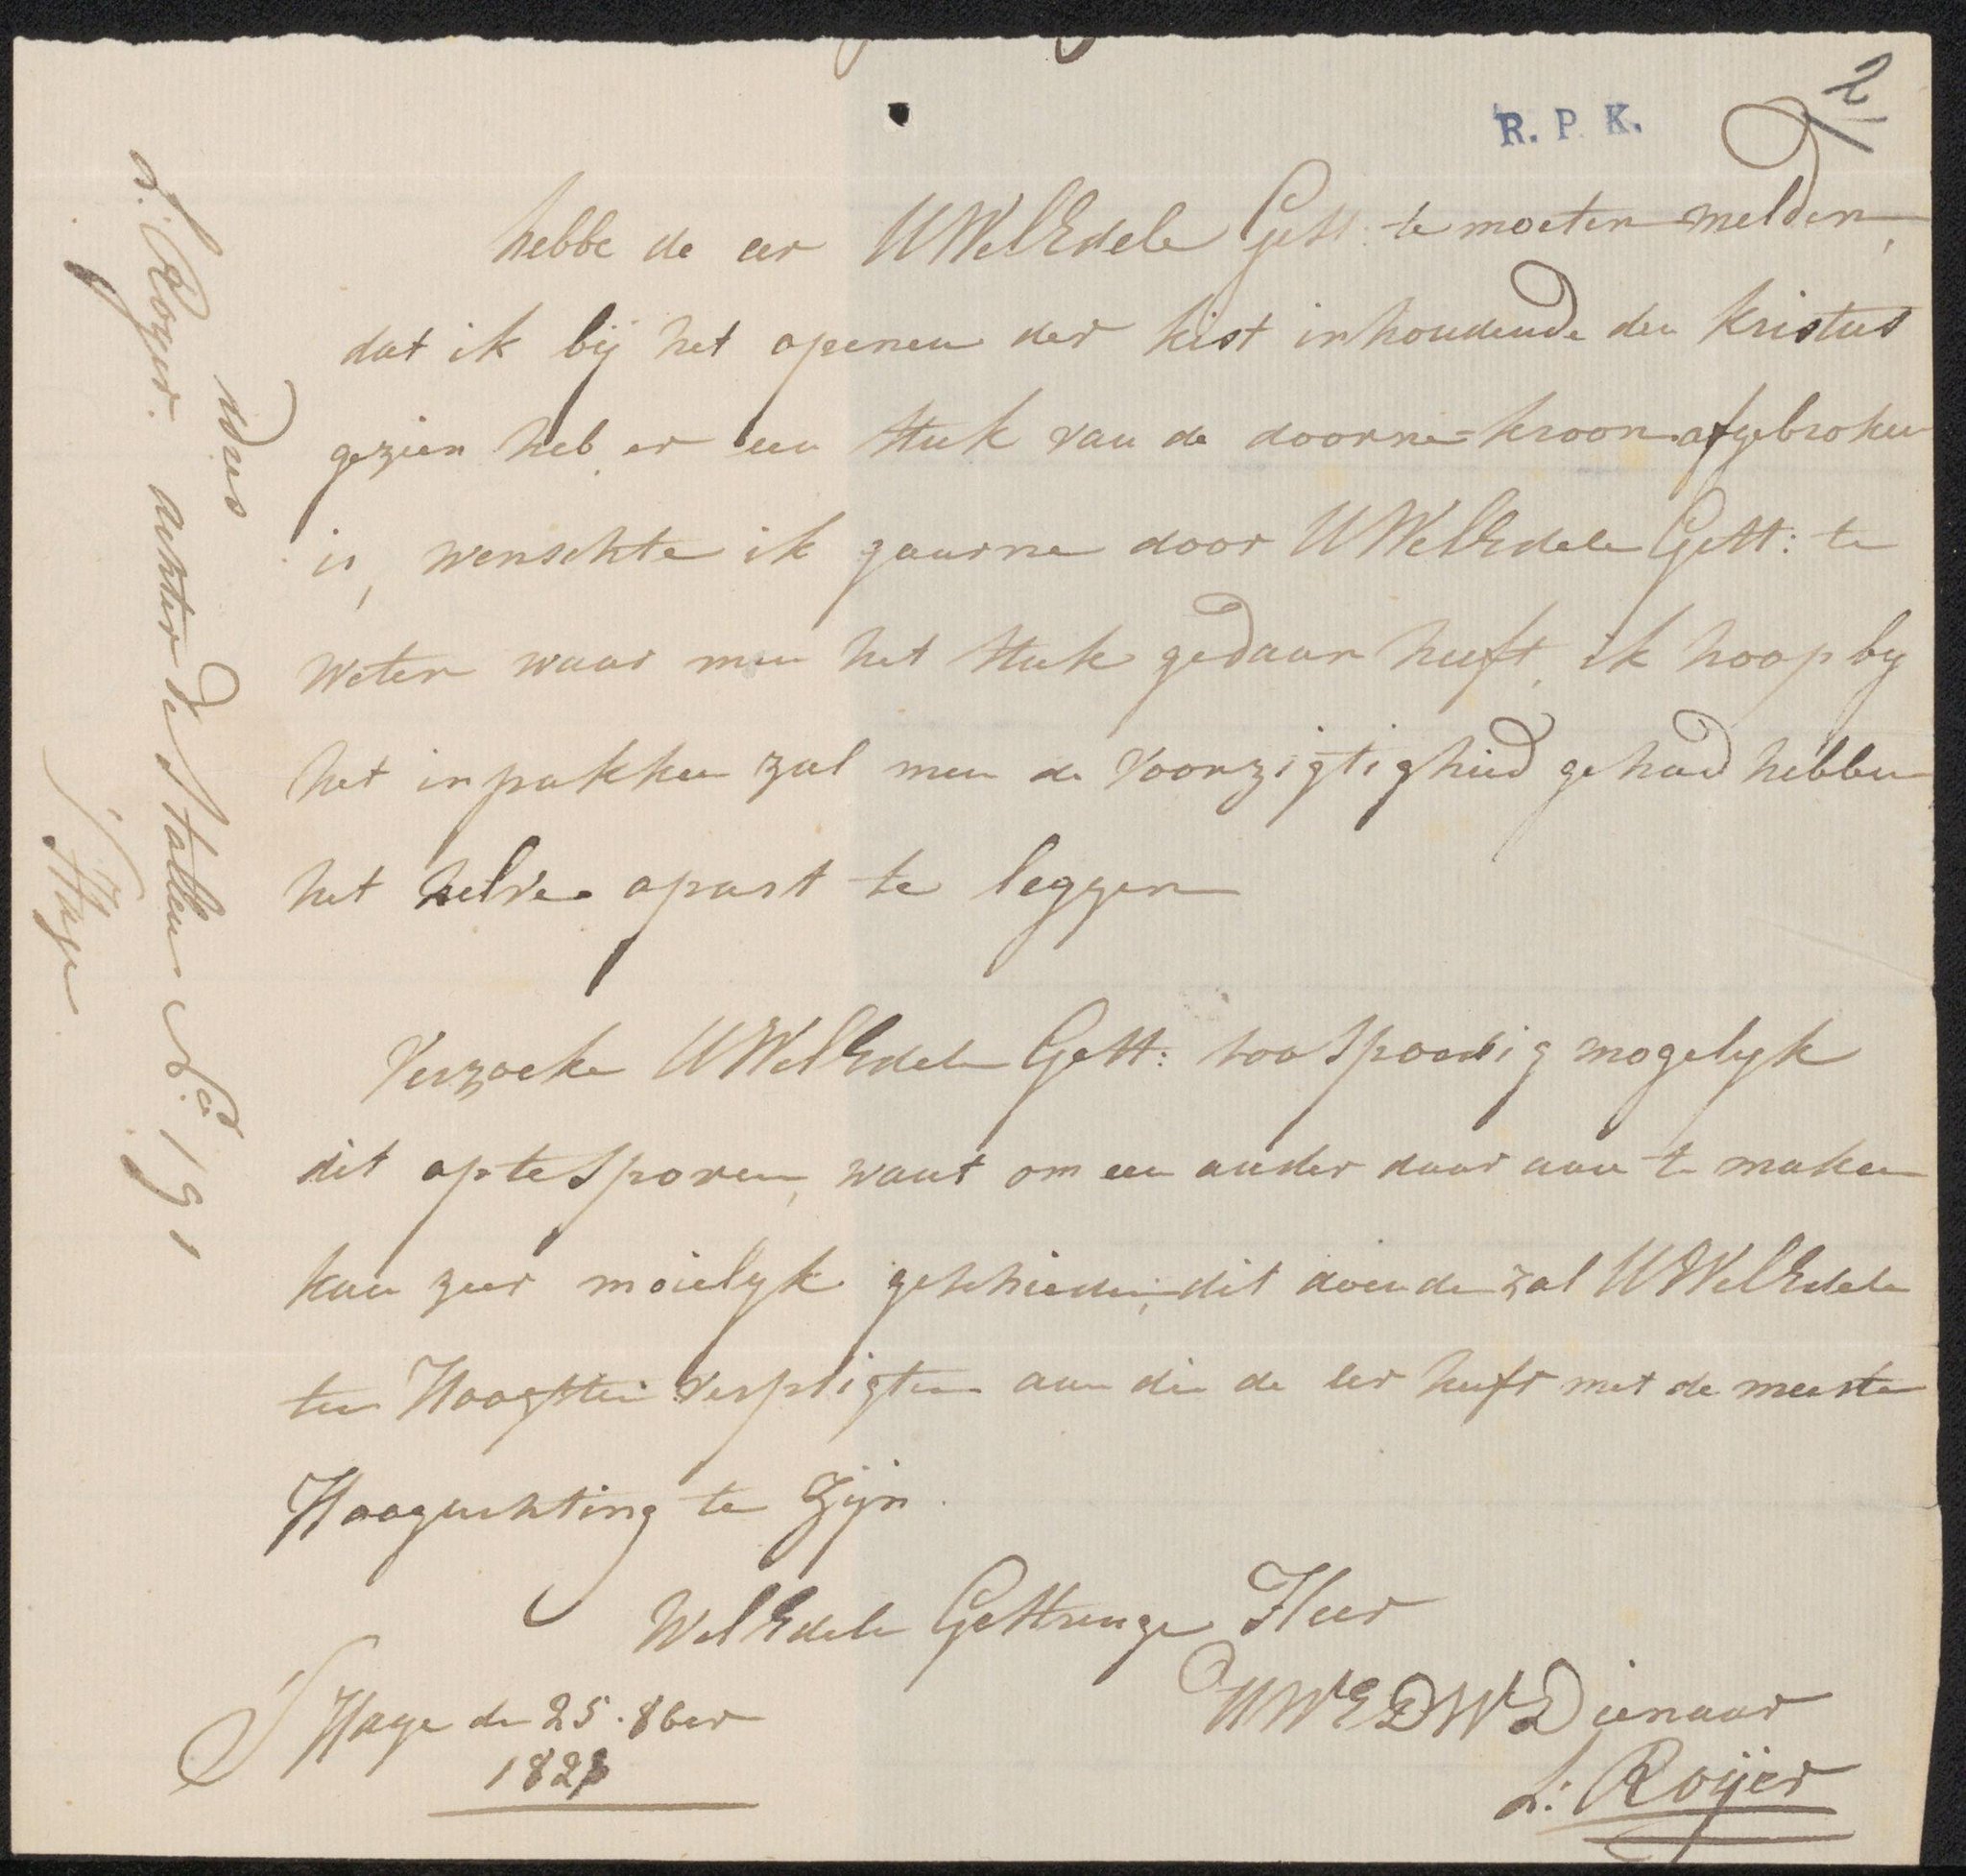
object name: letter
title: Brief aan anoniem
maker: louis royer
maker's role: draughtsman, sculptor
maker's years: 1793-1868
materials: ink, paper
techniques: pen, writing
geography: the hague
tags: money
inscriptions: seal, watermark, collector's mark: Lugt 2233